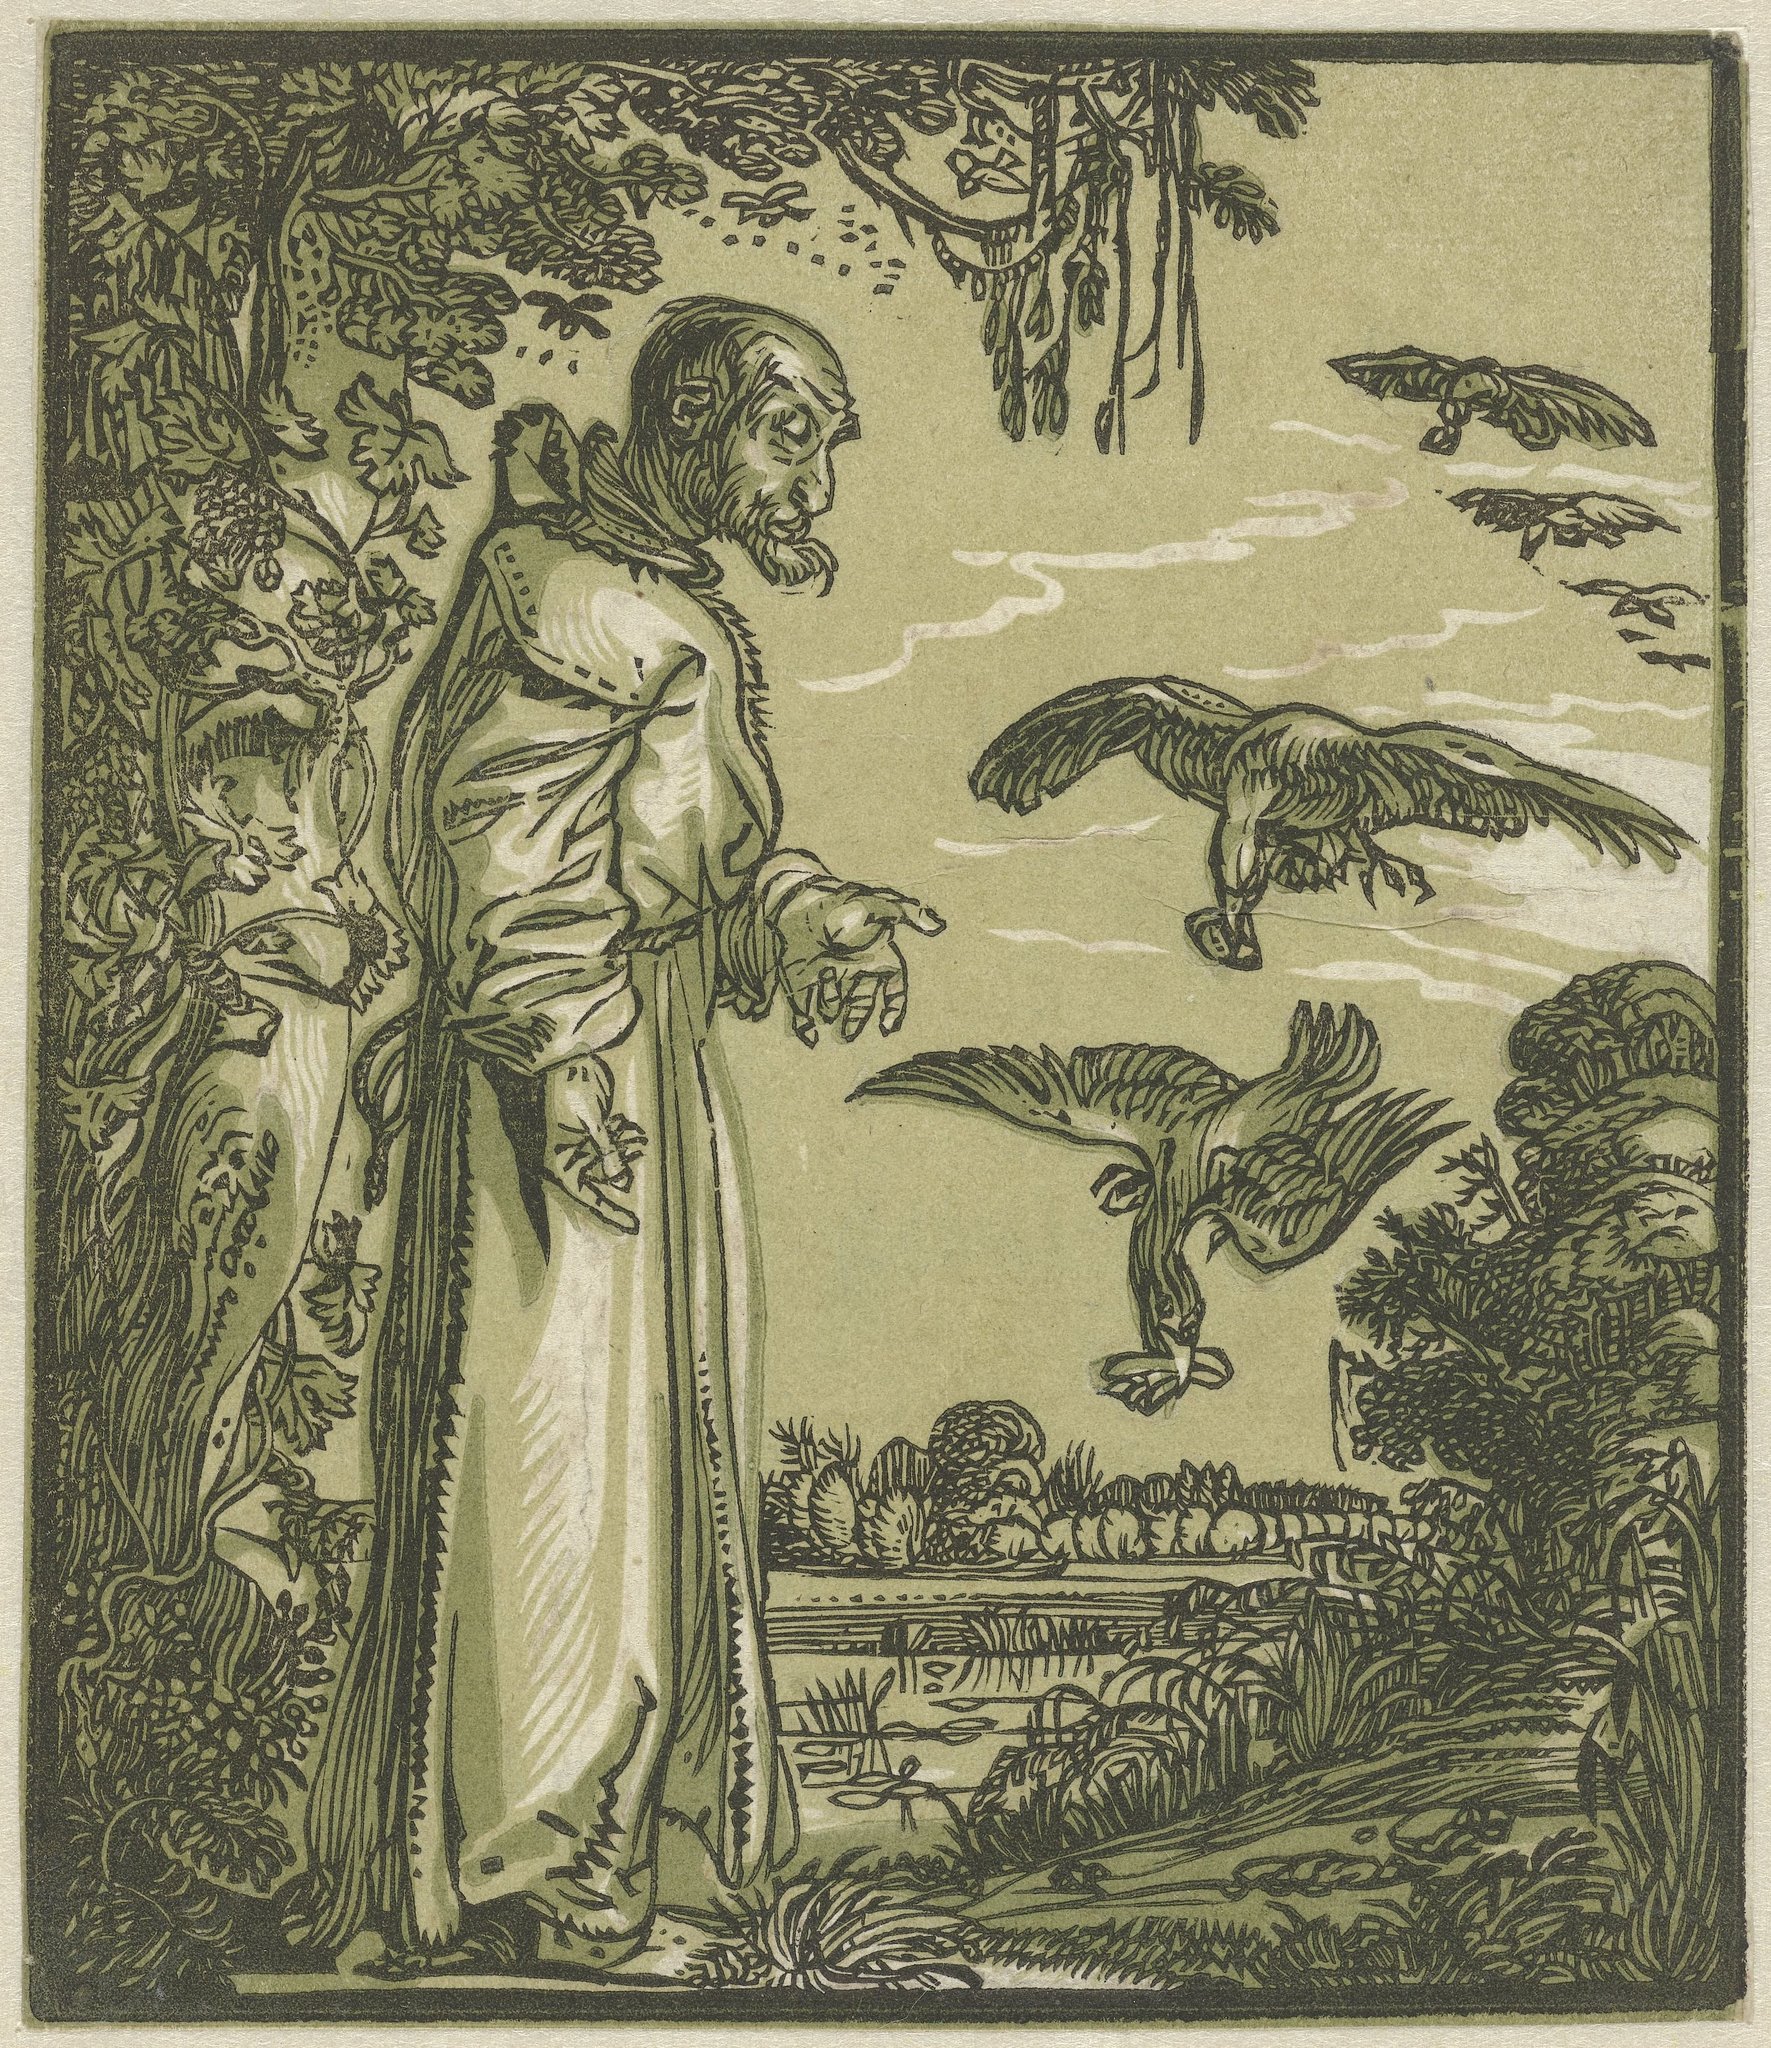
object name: print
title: Paulus de Kluizenaar (Elia?) gevoed door raven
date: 1612-1614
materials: paper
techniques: woodcut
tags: st. paul the hermit in the desert, with a long beard and wearing a loincloth of woven palm-leaves, is fed with bread by a raven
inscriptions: collector's mark: Lugt 2228a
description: Een man, ten voeten uit, in monnikskleed, staat bij een boom. Een aantal vogels (raven) komt aanvliegen met brood in de bek.